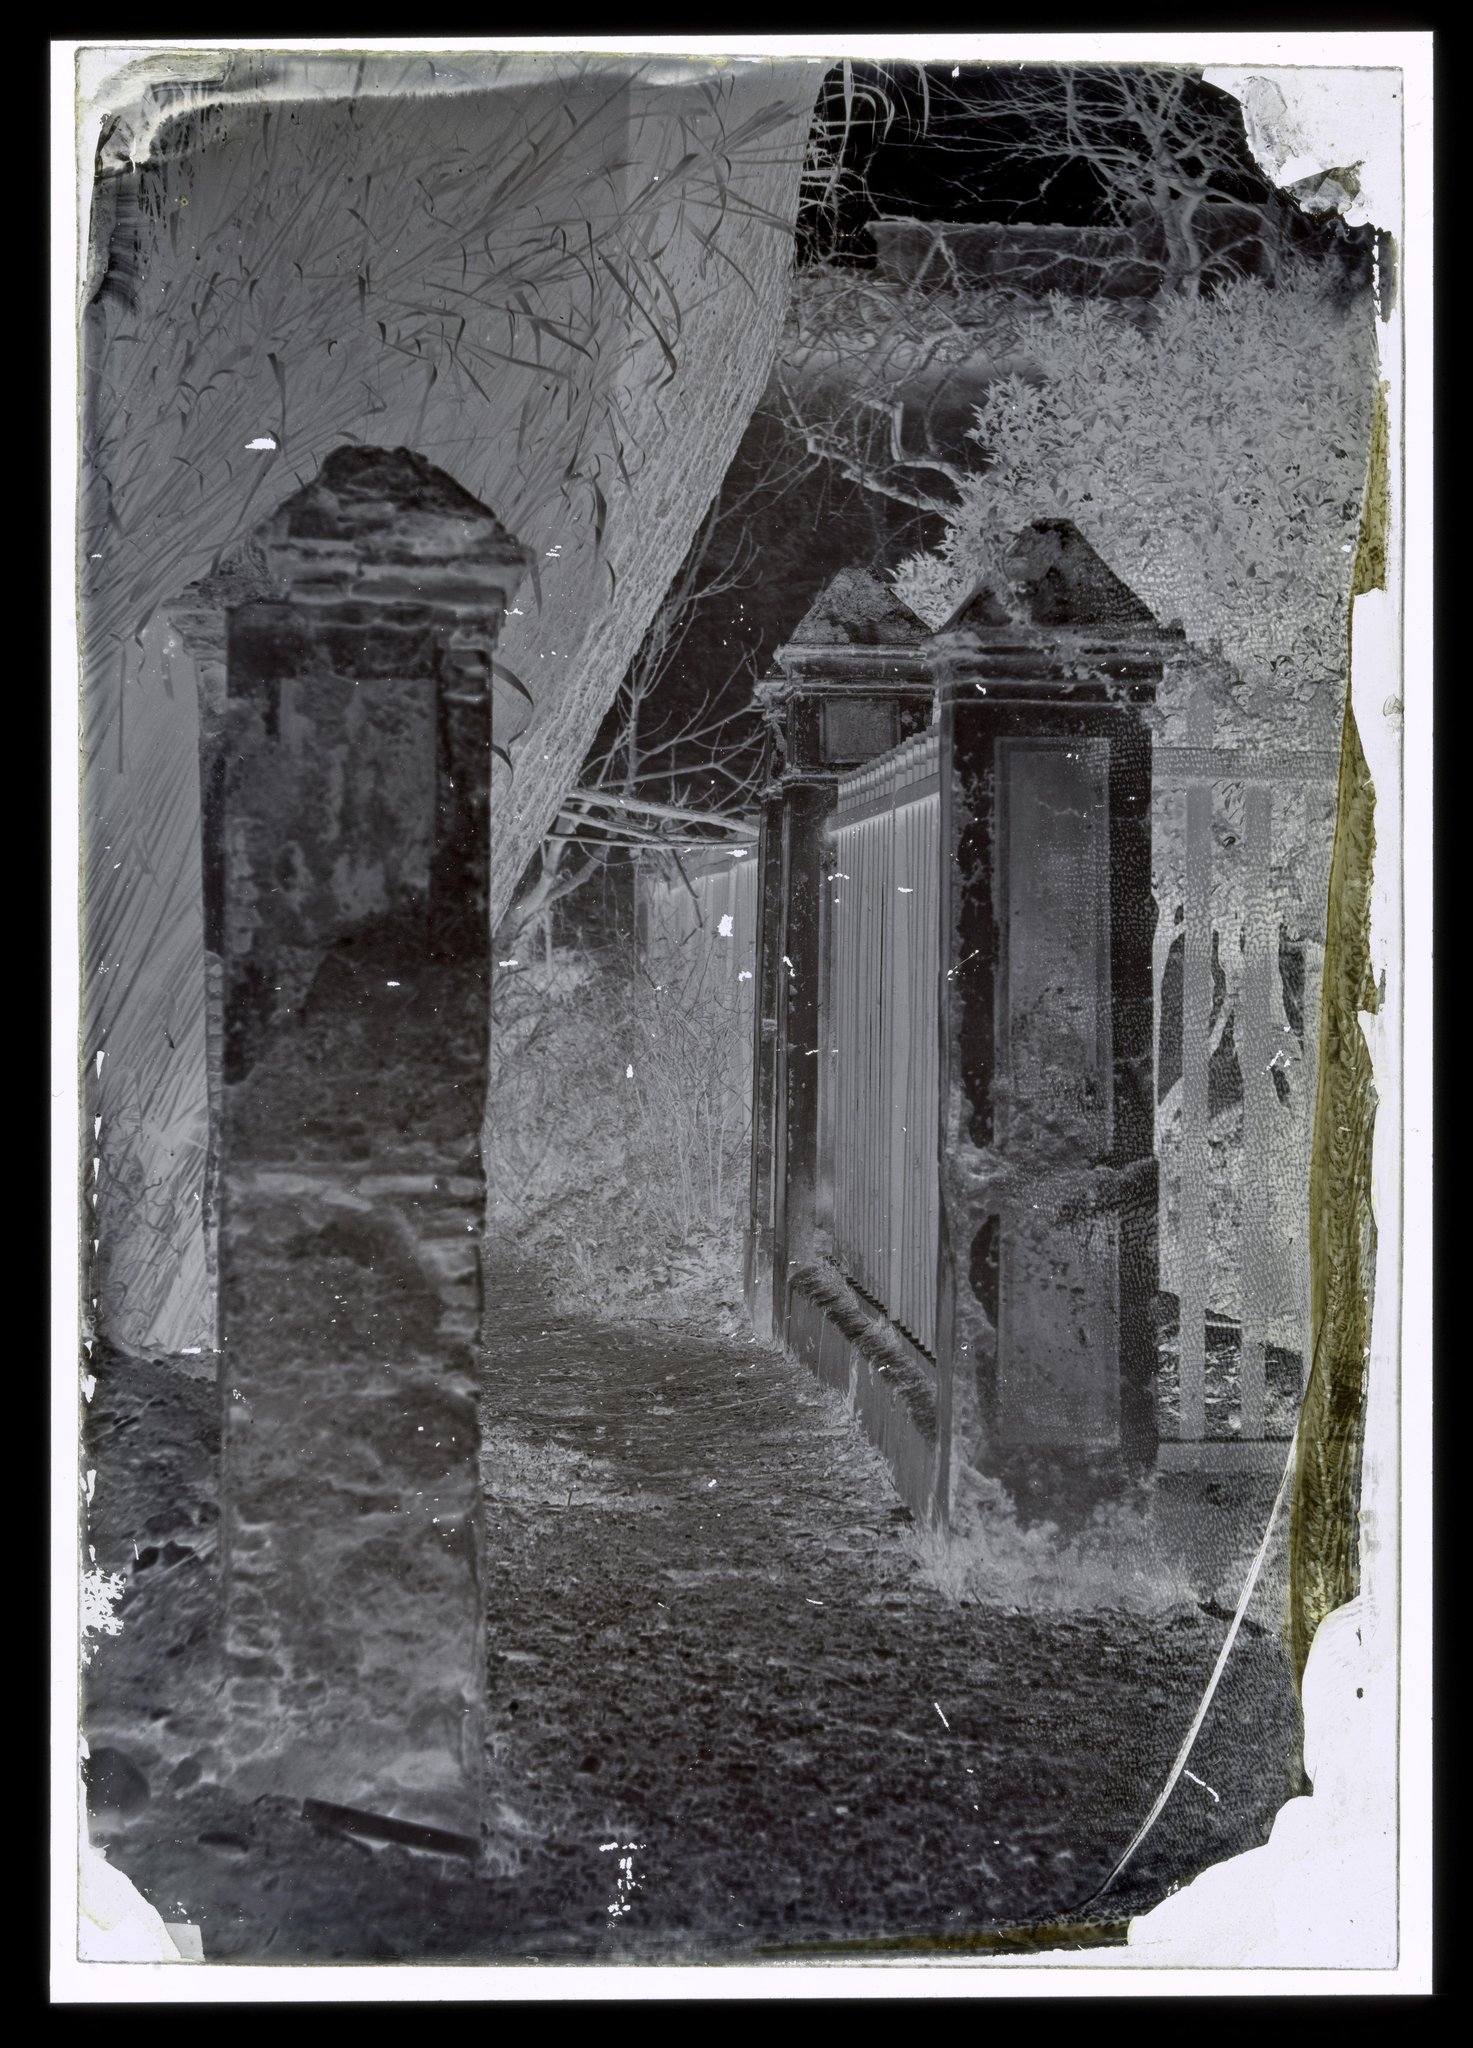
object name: glasnegatief, glasplaatnegatief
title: Gezicht in een tuin, vermoedelijk in Rome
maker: laurens lodewijk kleijn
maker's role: draughtsman, painter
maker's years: 1826-1909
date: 1851-1868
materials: glass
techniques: collodion process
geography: rome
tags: garden, rome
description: Onderdeel van een groep glasnegatieven uit de nalatenschap van de schilder Laurens Lodewijk Kleijn, met stillevens, portretten, zelfportretten en kunstreproducties.